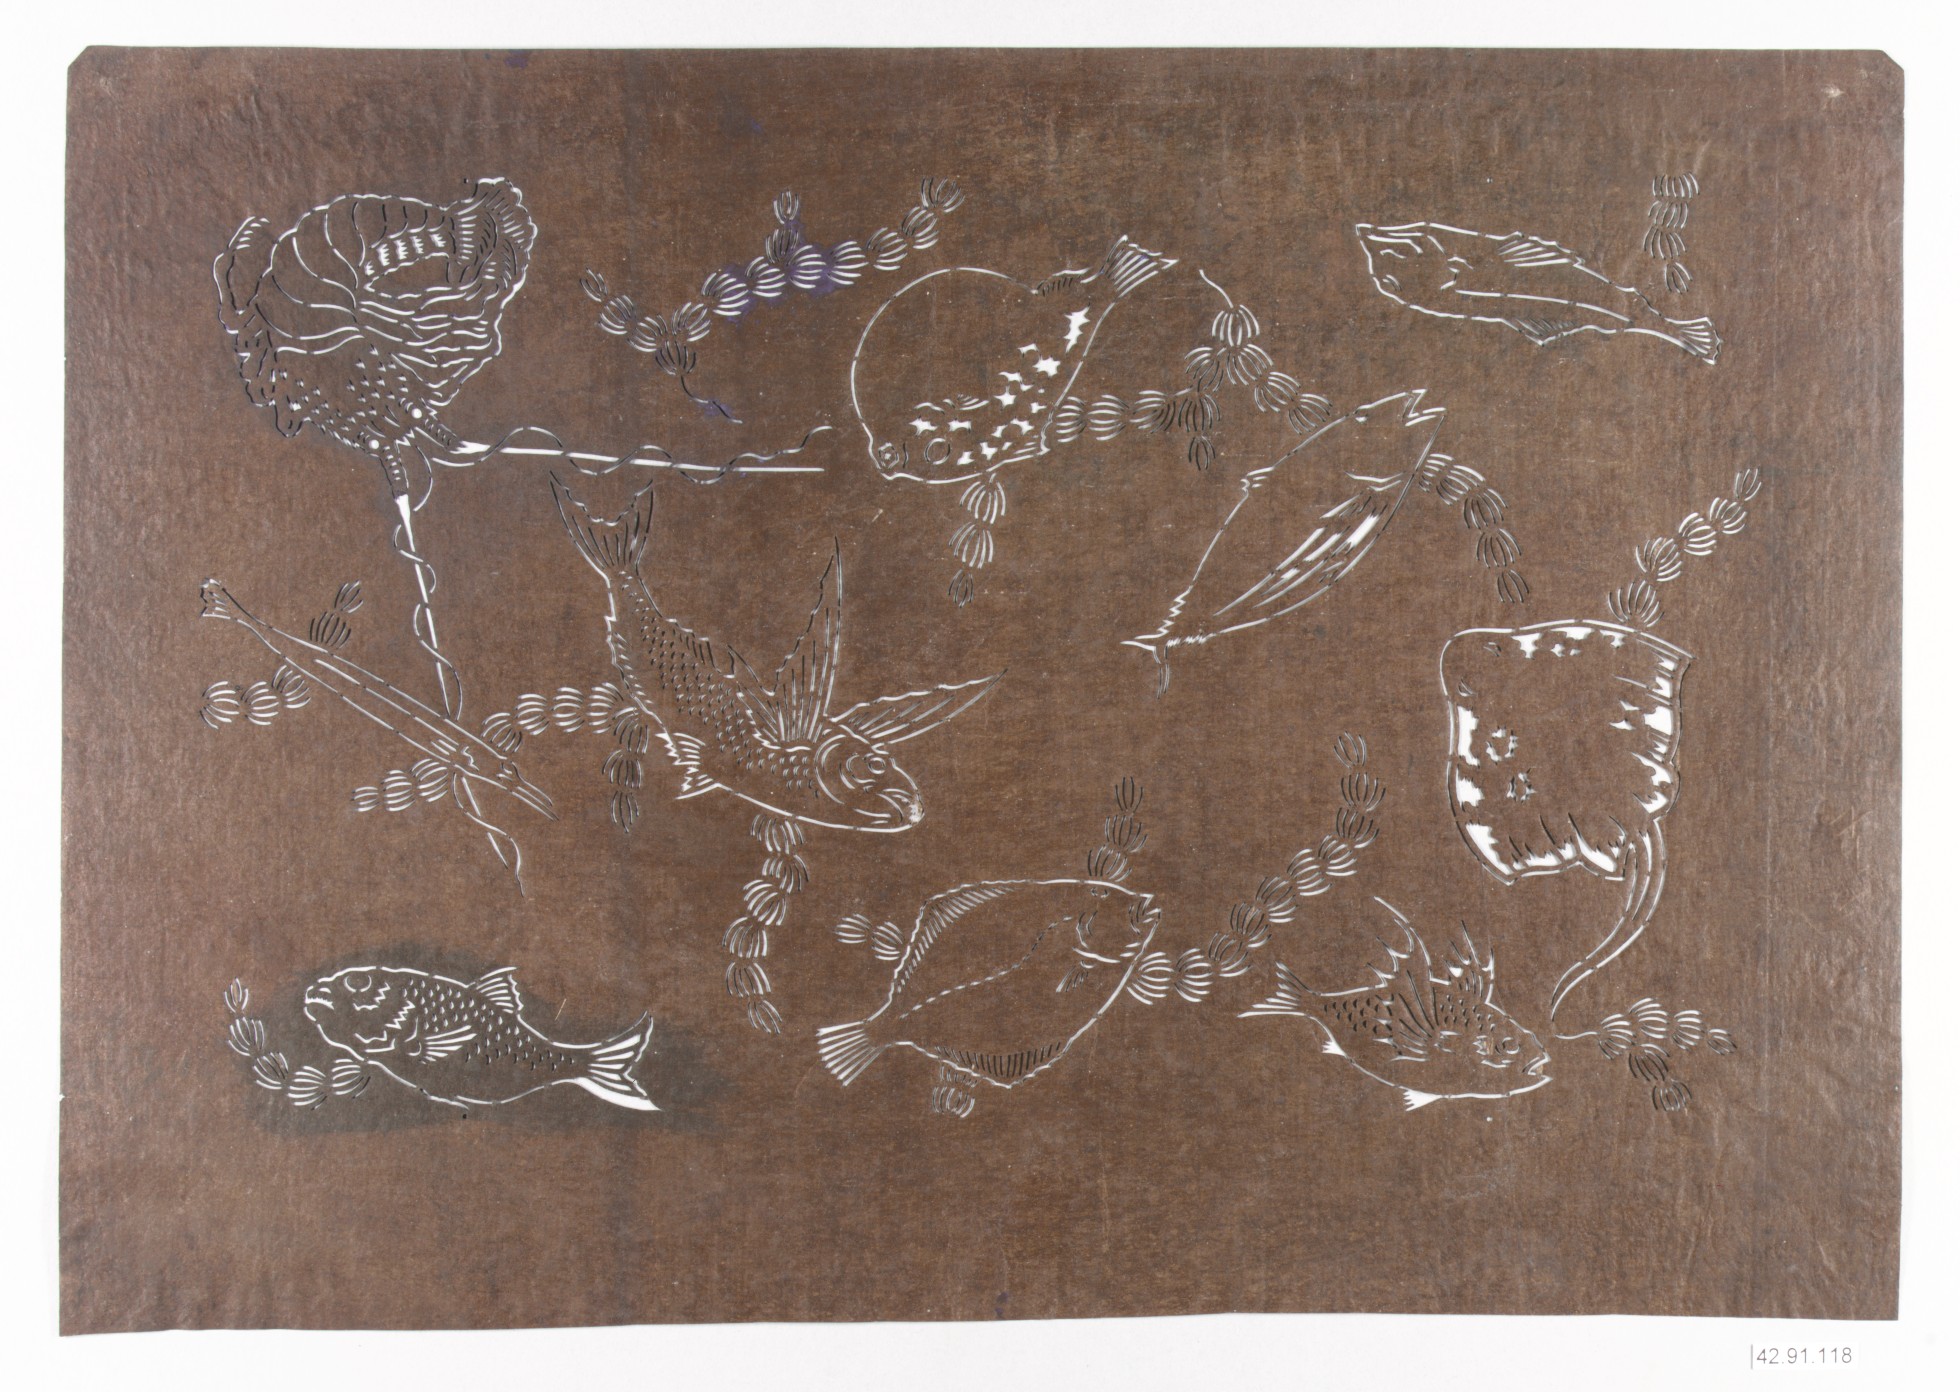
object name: stencil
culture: japanese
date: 1801-1900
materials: paper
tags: fish